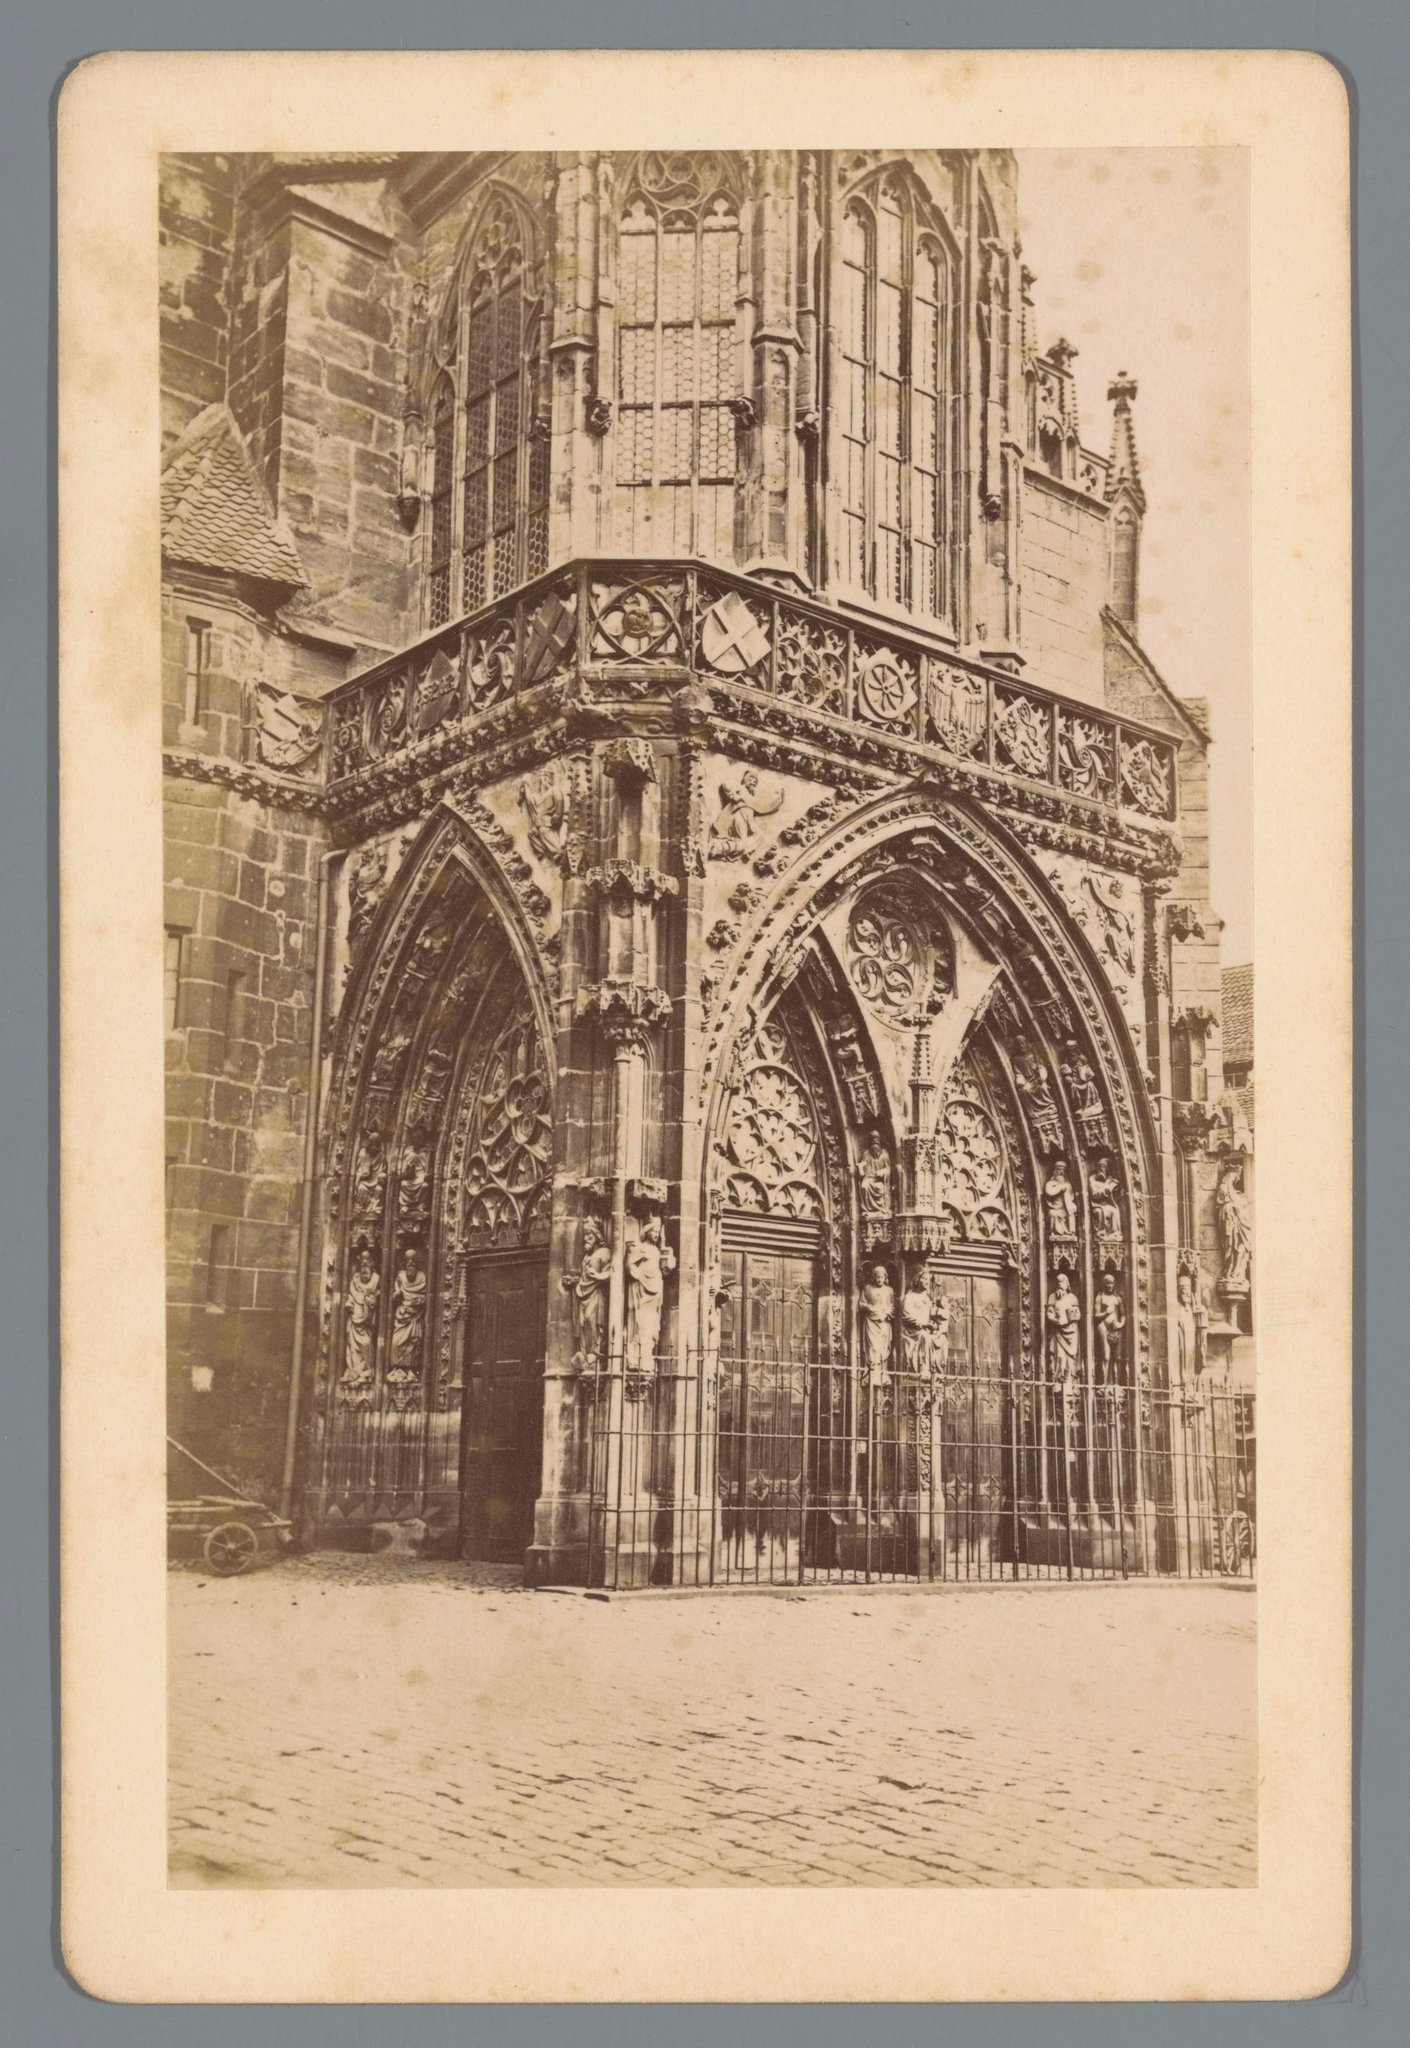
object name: cabinet photograph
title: Portal der Liebfrauenkirche II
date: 1863-1898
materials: cardboard, photographic support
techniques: albumen print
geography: frauenkirche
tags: church (exterior), gate, entrance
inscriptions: number: ‘11.’